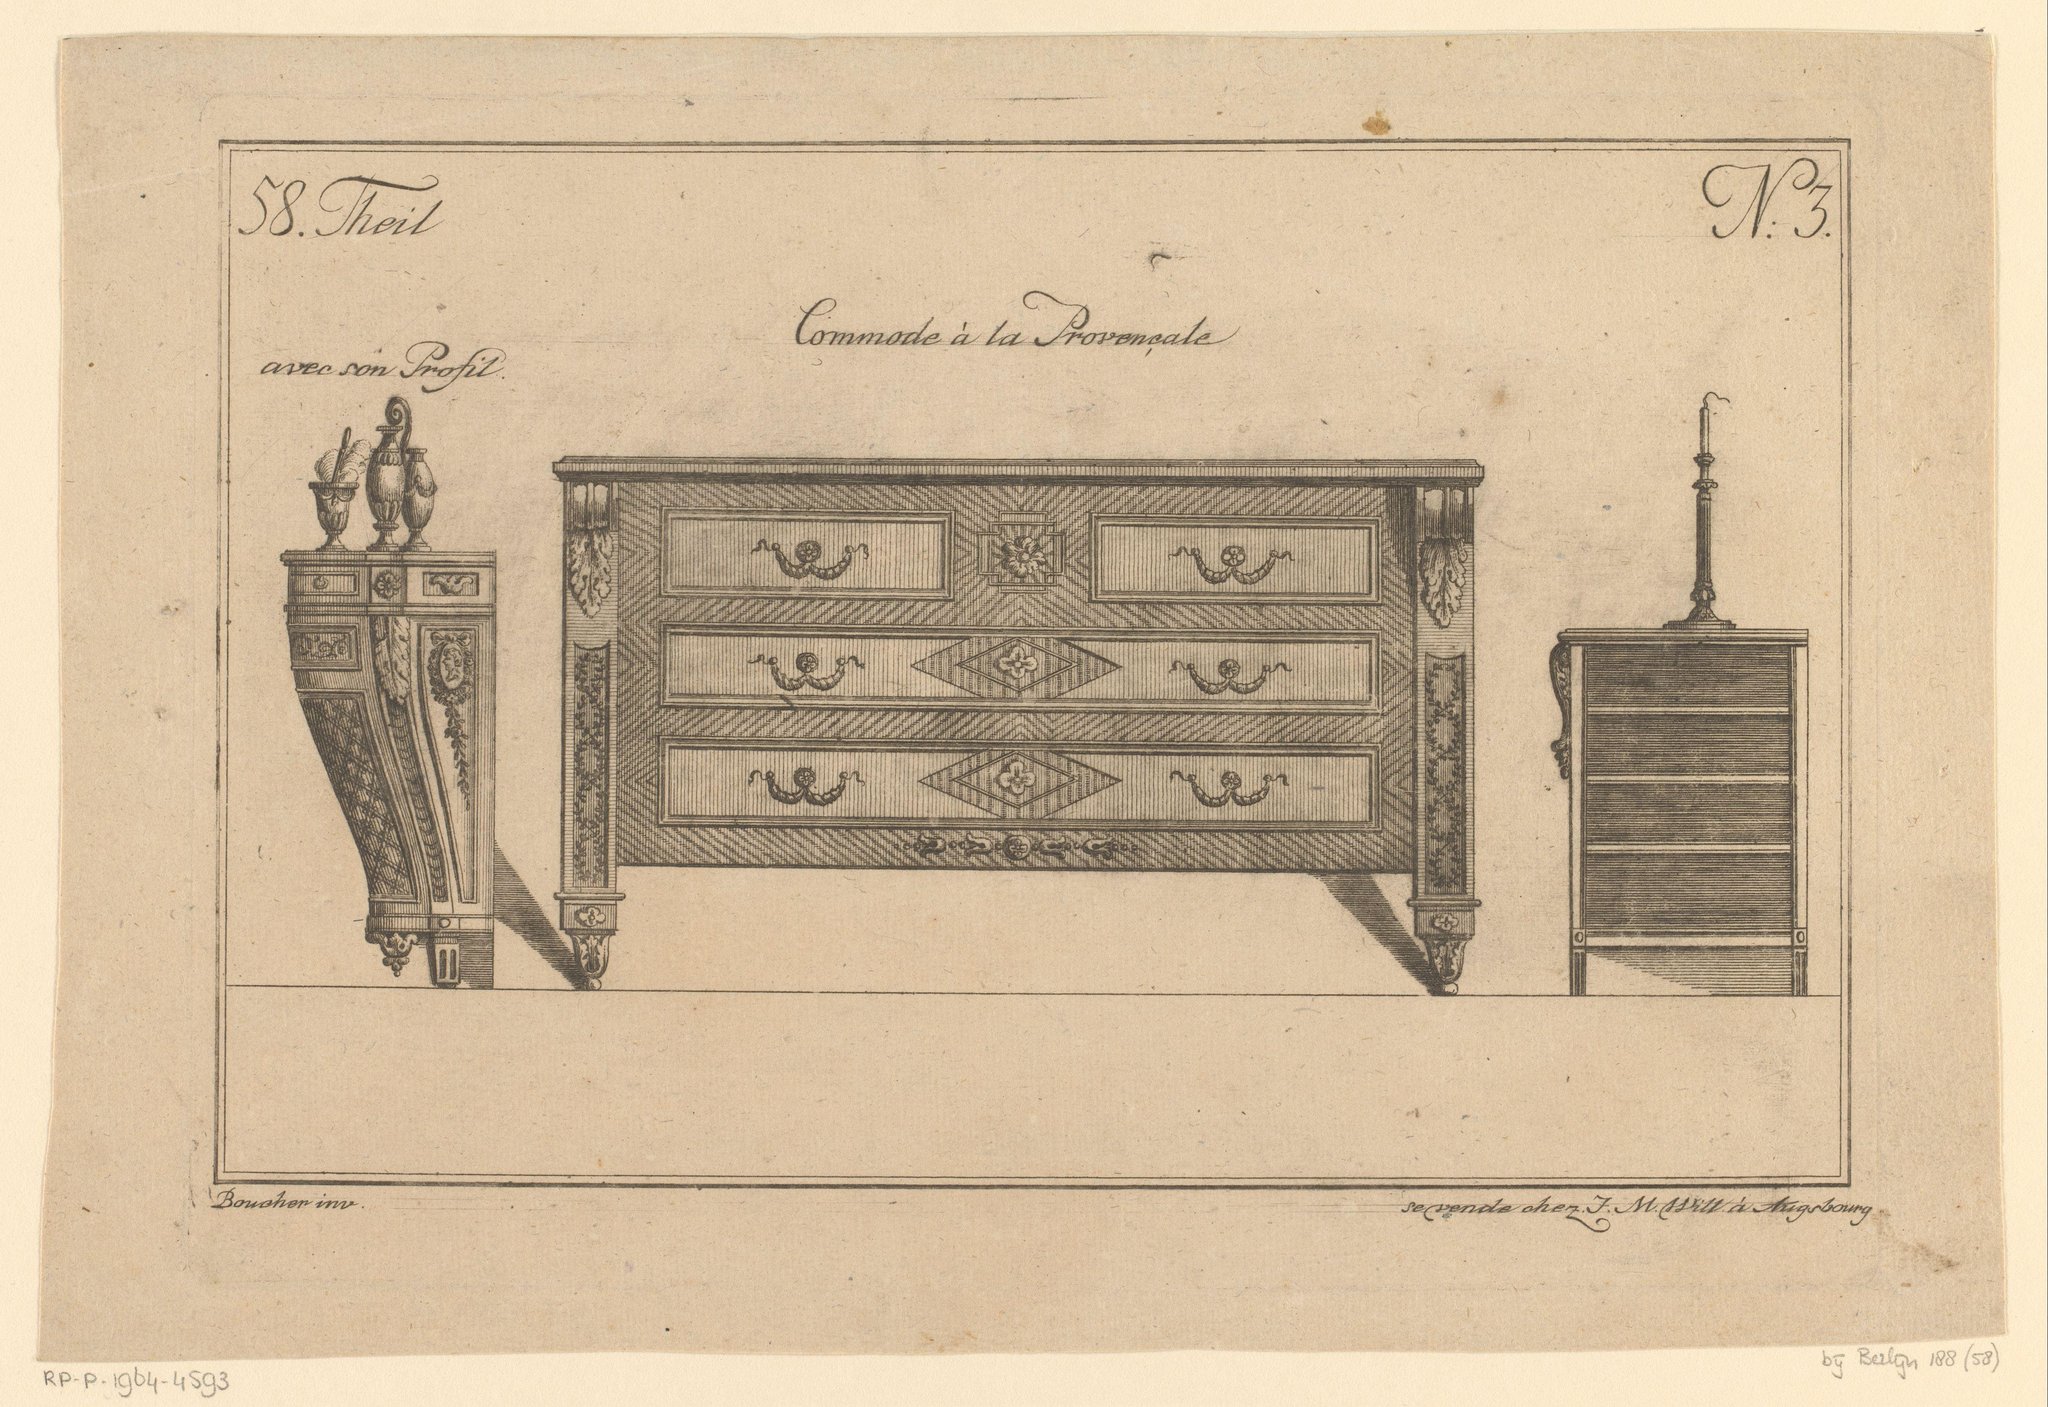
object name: print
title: 58. Theil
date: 1746-1782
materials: paper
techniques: engraving, etching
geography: augsburg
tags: ornamental cupboard, chandelier, candelabrum, container of stone: stone vase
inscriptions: collector's mark: Lugt 2760, collector's mark: Lugt 2228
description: Voor- en zijaanzichten van een ladekast met bladmotieven. Op de linkerkast staan vazen, rechts staat een kandelaar.